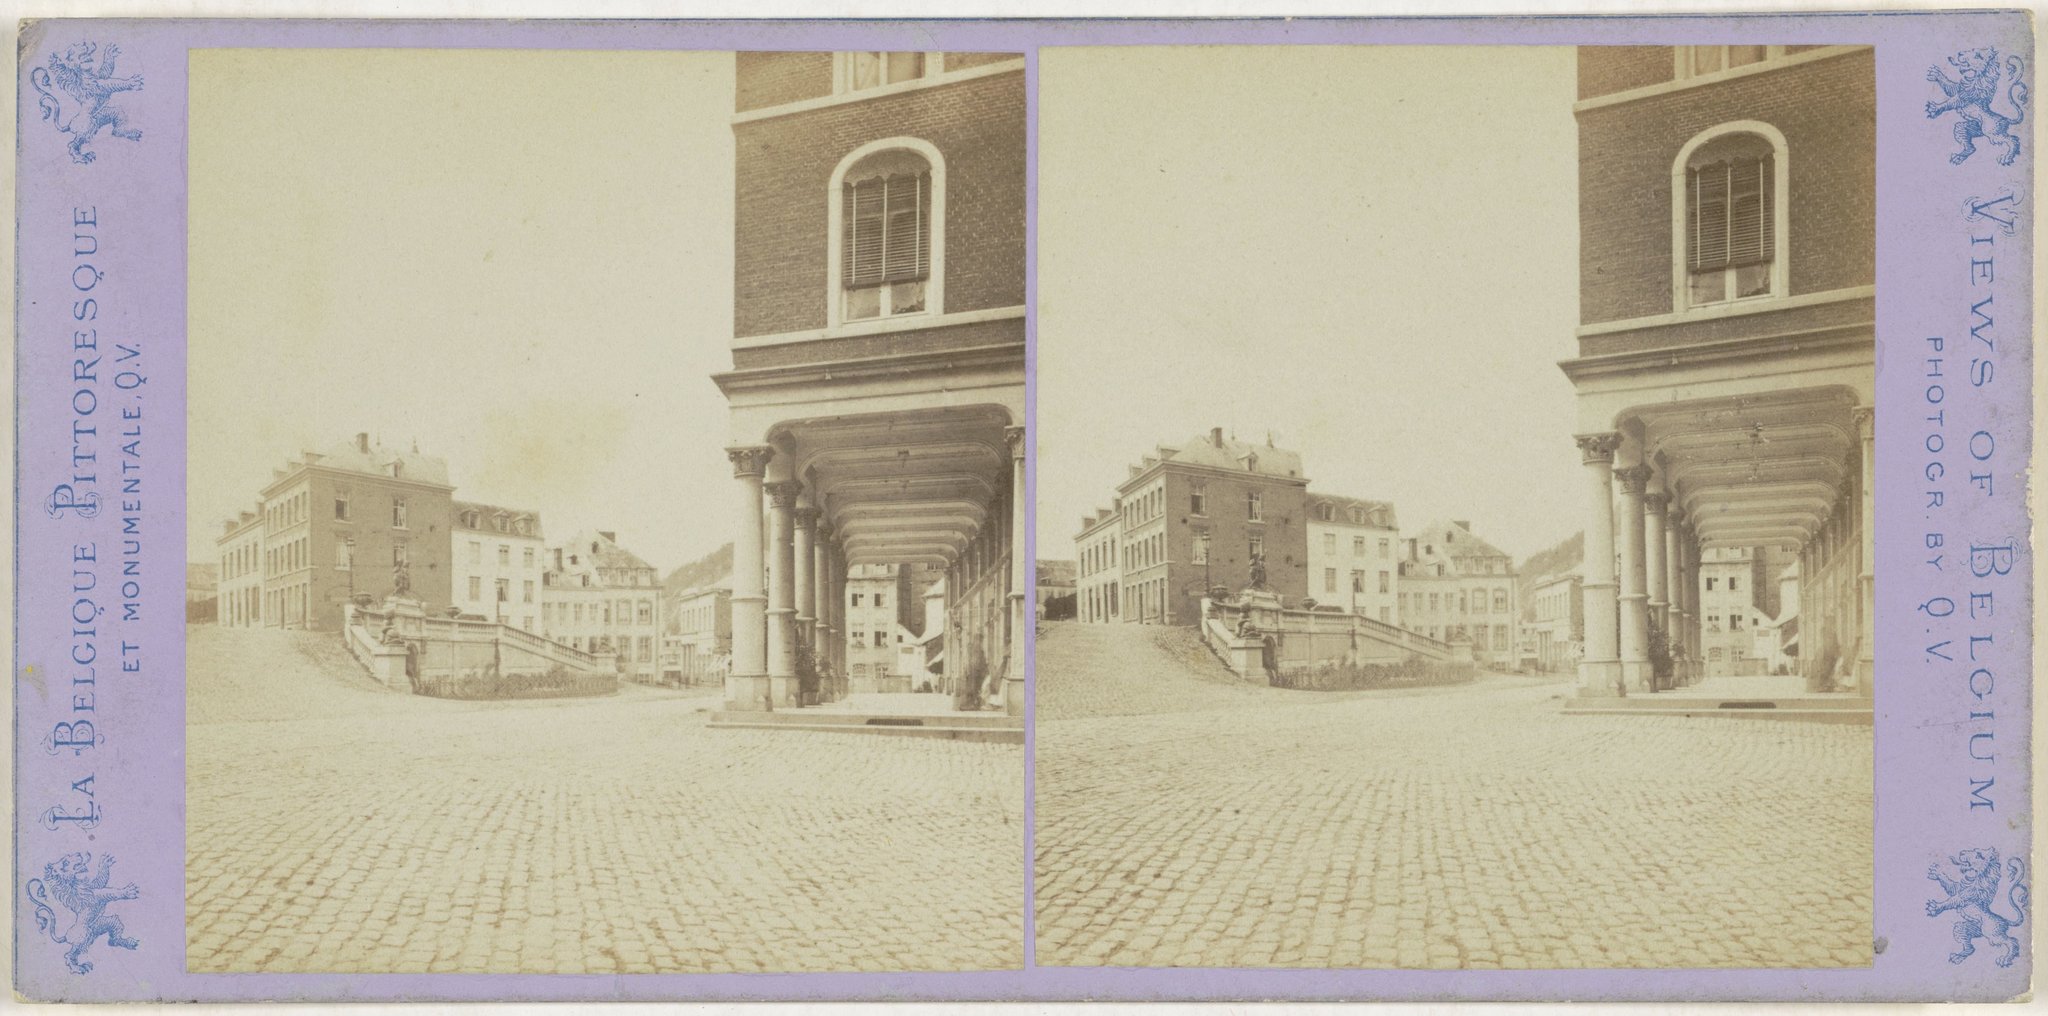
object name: stereograph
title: Gezicht op de achterkant van de Peter-de-Grotebron en de Cascade Monumentale in Spa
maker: jules hippolyte quéval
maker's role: publisher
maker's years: 1824-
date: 1866-1870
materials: cardboard, paper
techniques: albumen print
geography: spa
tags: ornamental fountain, hotel, hostelry, inn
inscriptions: number: ‘1797’